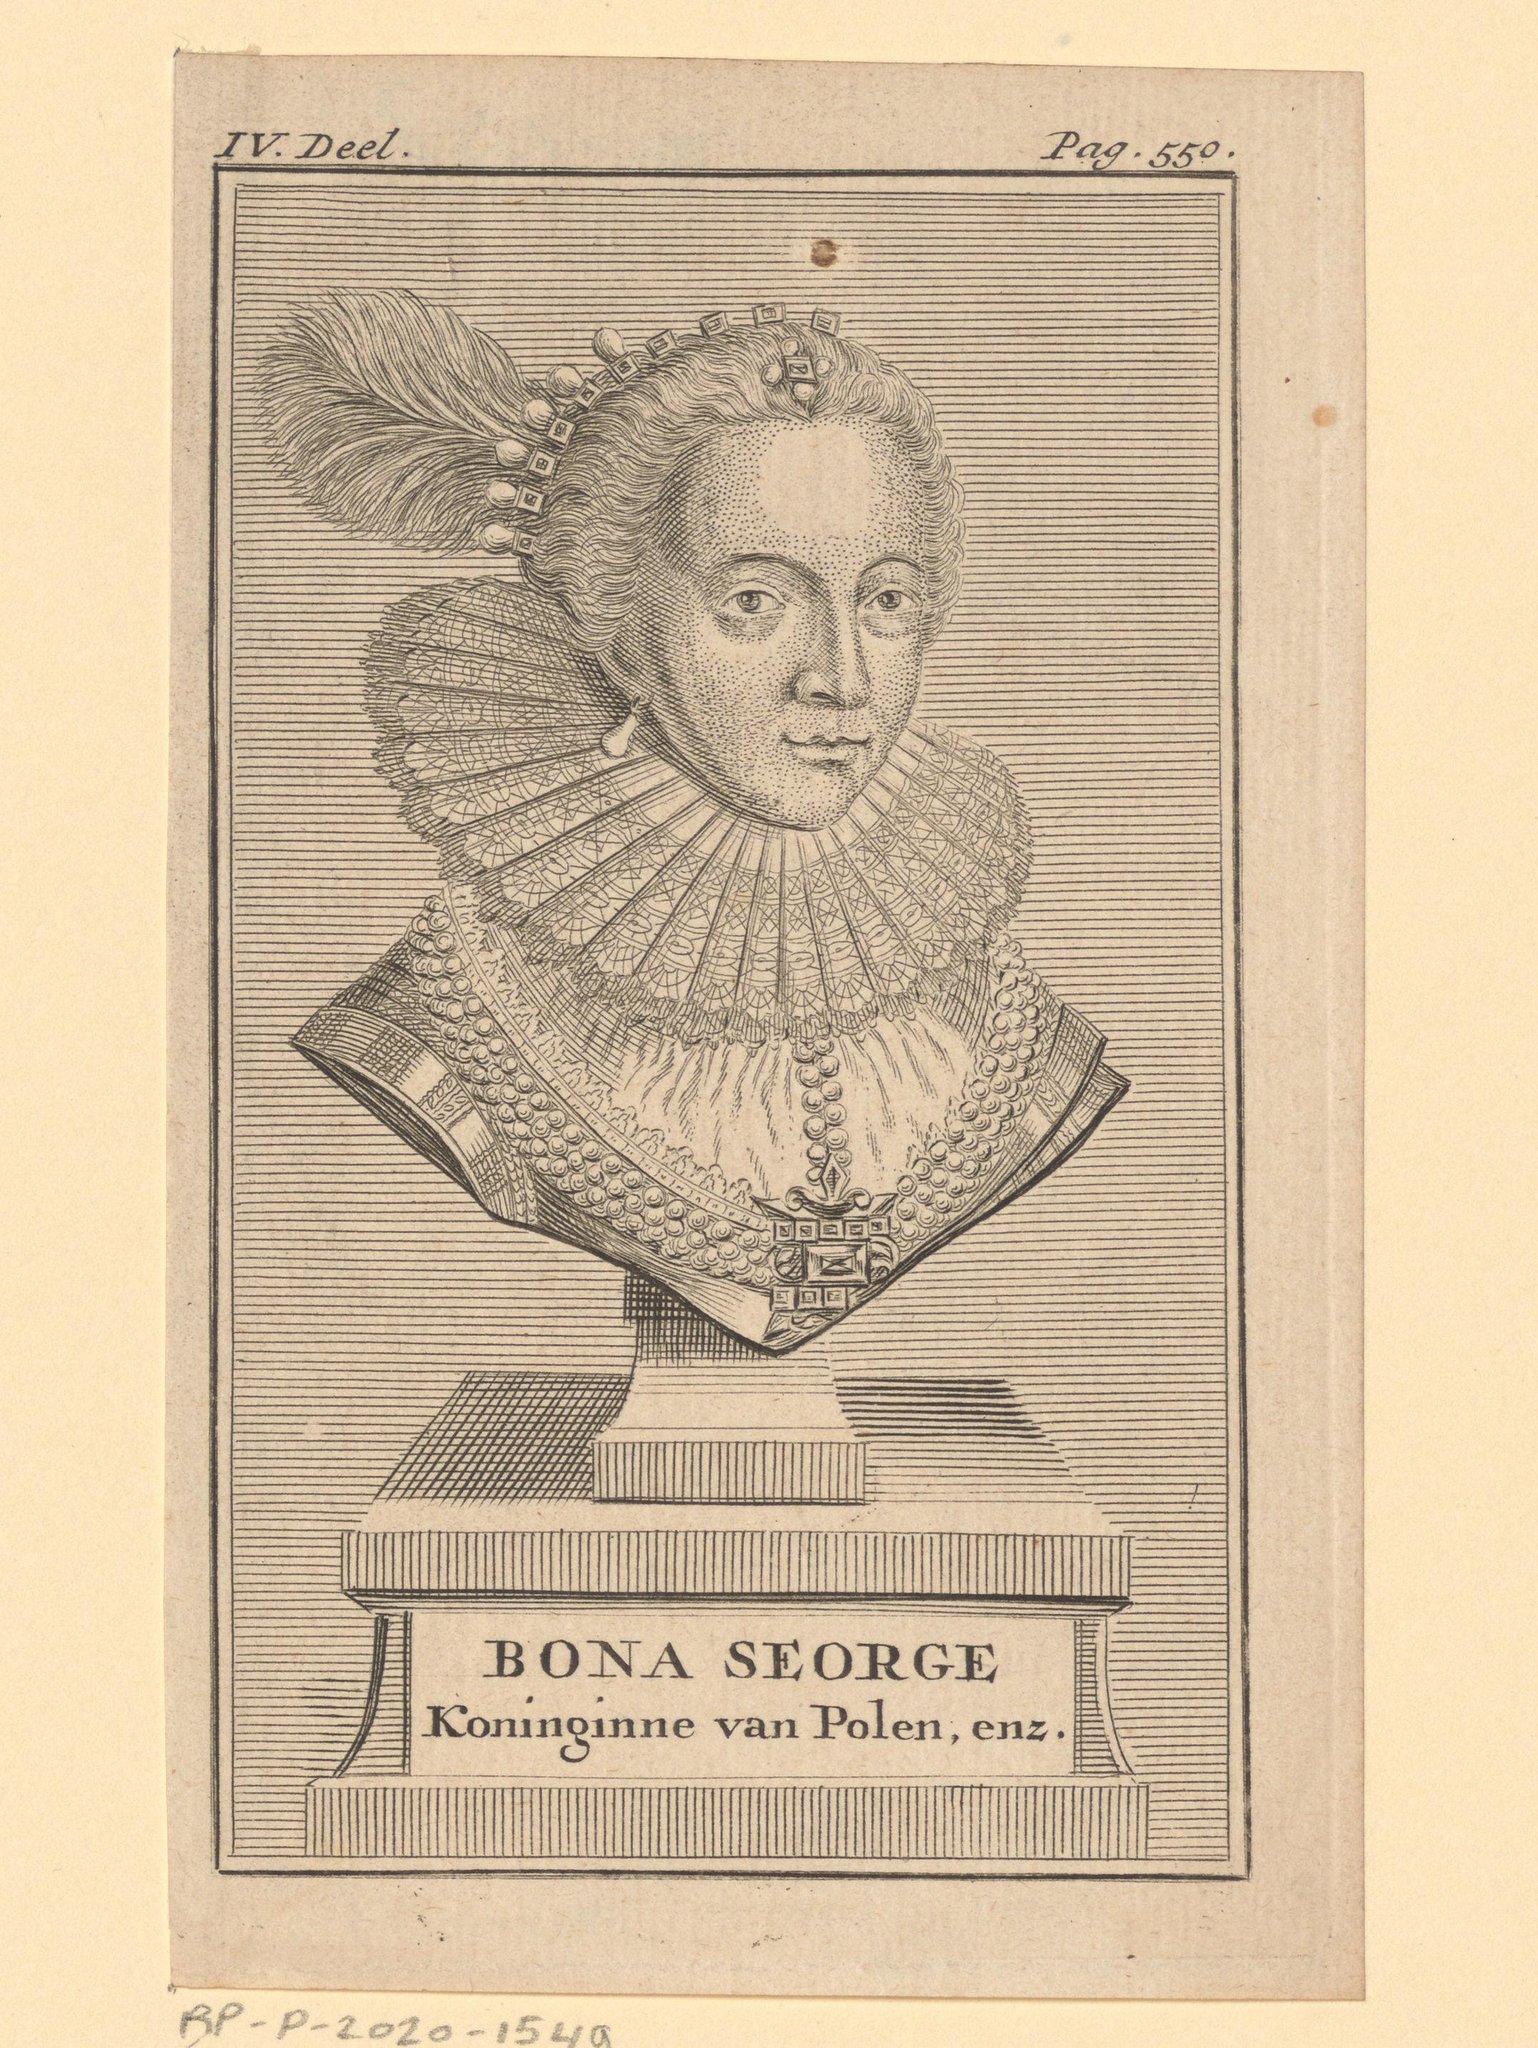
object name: print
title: Portret van Bona Sforza, koningin van Polen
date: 1735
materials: paper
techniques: engraving, etching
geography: amsterdam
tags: historical persons - bb - woman, queen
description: Prent uit: Leti, Gregorio. Het leven van keizer Karel, den Vyfden. Amsterdam: Johannes en Geertrui de Ruyter, 1735, dl. 4. Prent ook verschenen in de tweede editie van 1738.